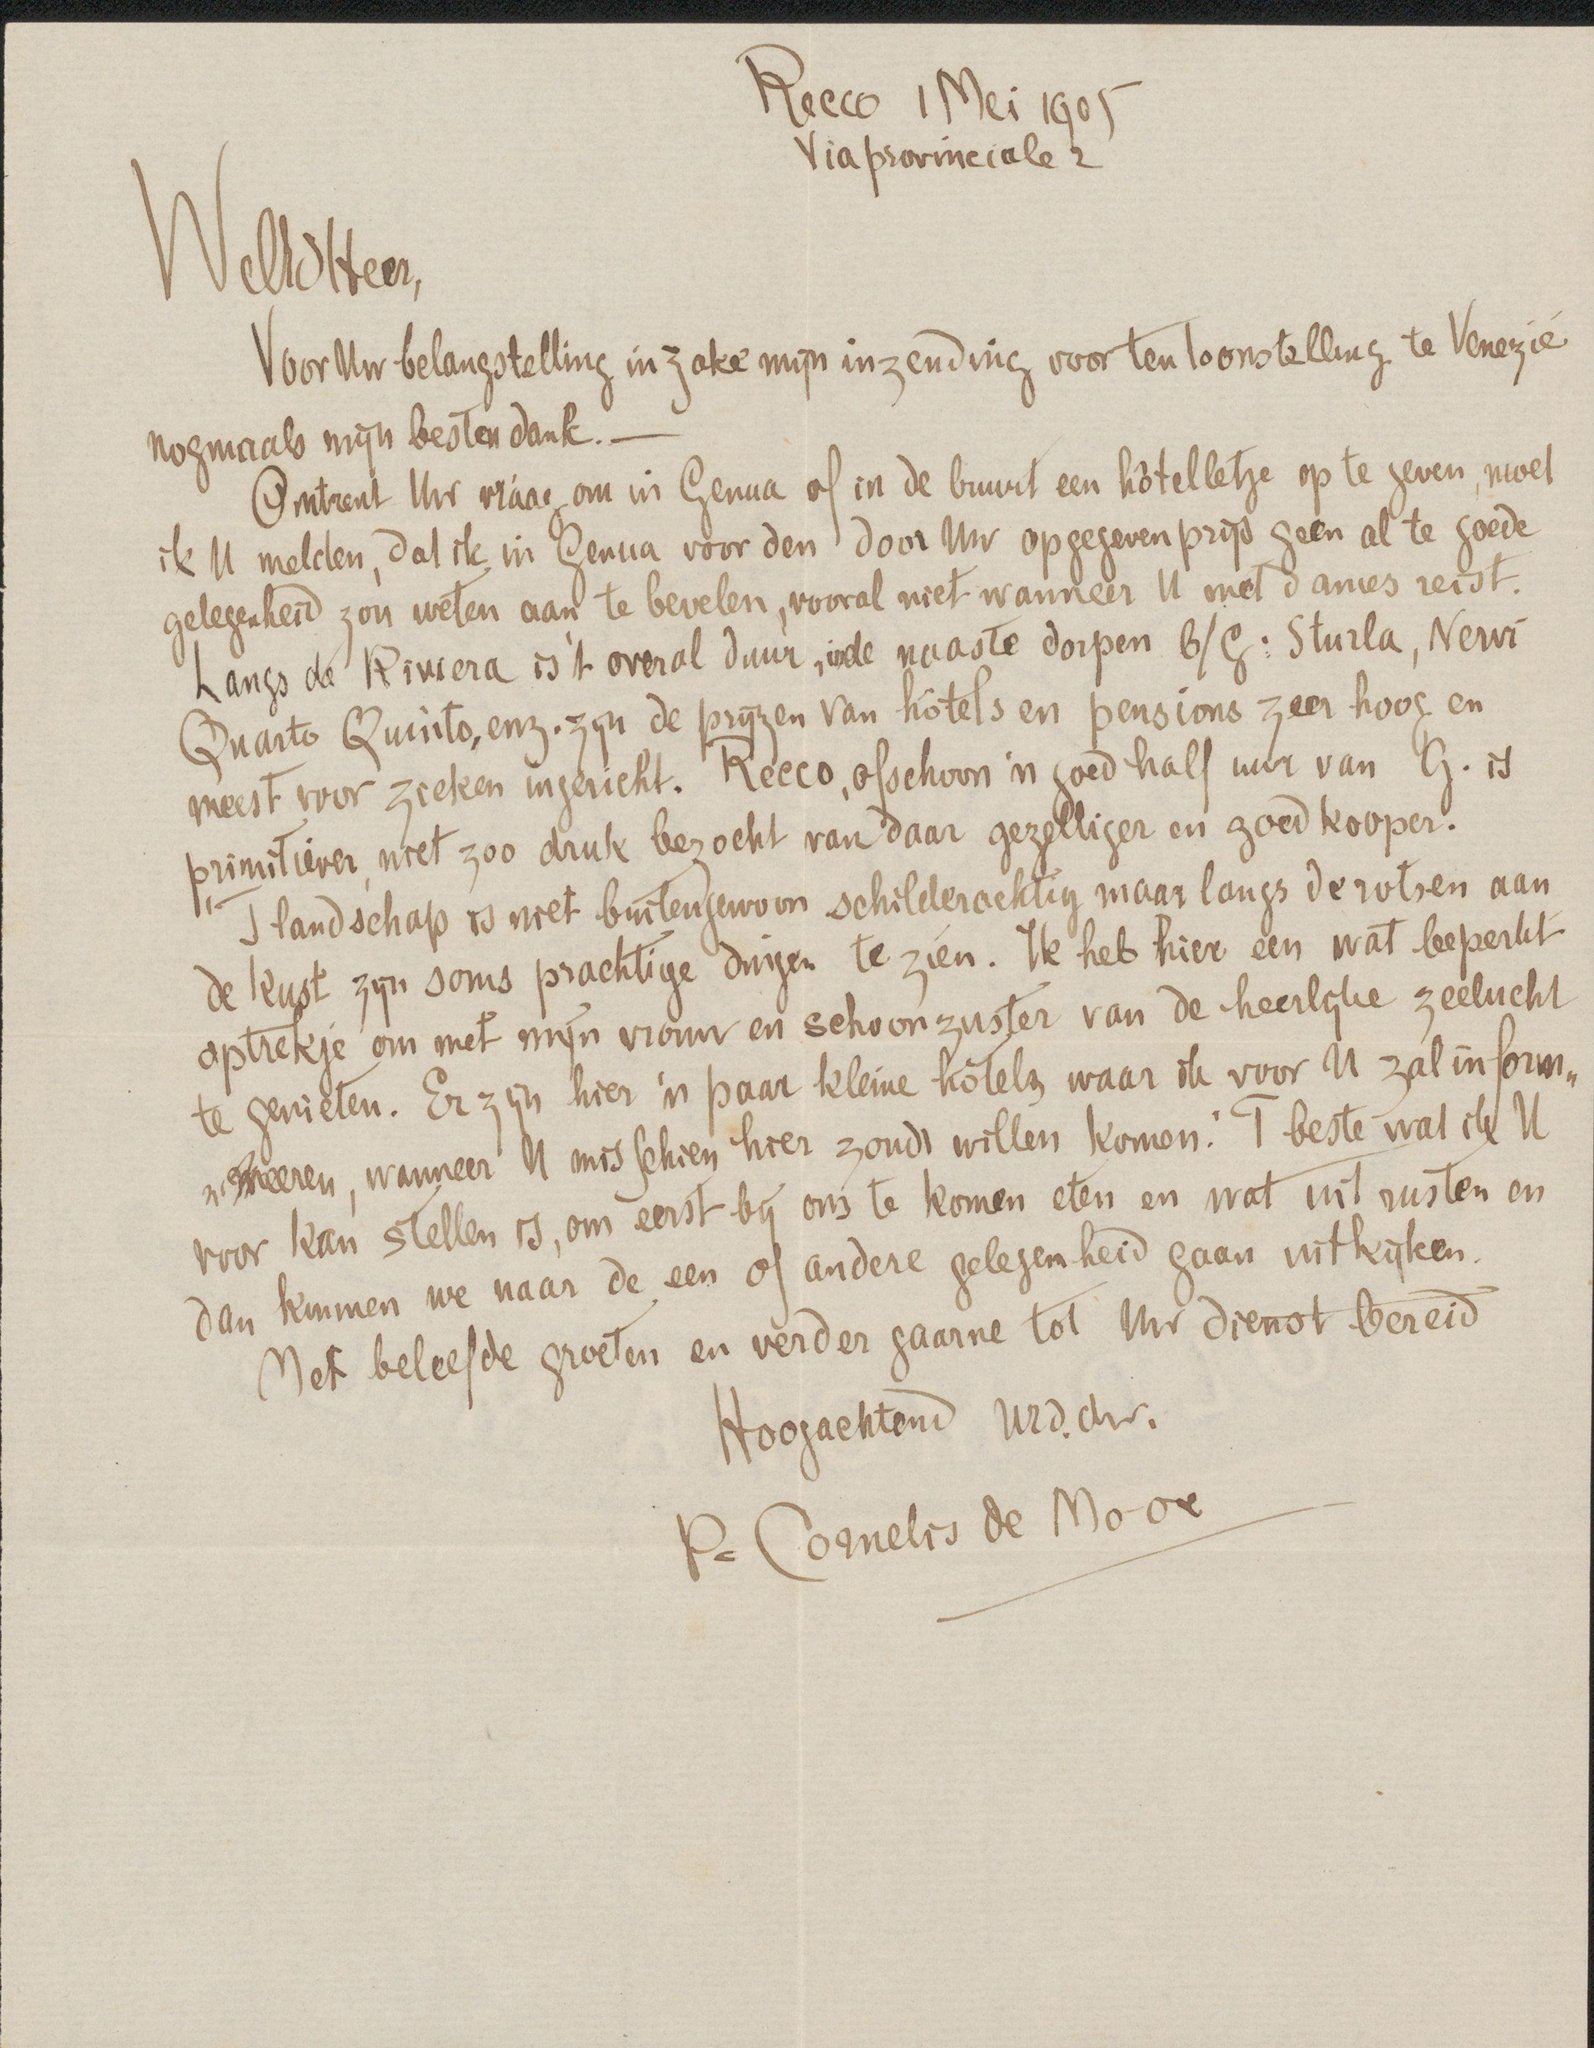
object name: letter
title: Brief aan Philip Zilcken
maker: pieter cornelis de moor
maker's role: draughtsman, print maker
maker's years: 1866-1953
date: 1905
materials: ink, paper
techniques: pen, writing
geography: recco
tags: the hague, painter, draughtsman, philip zilcken, exhibition ~ art, venice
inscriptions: collector's mark: ‘RPK’, watermark